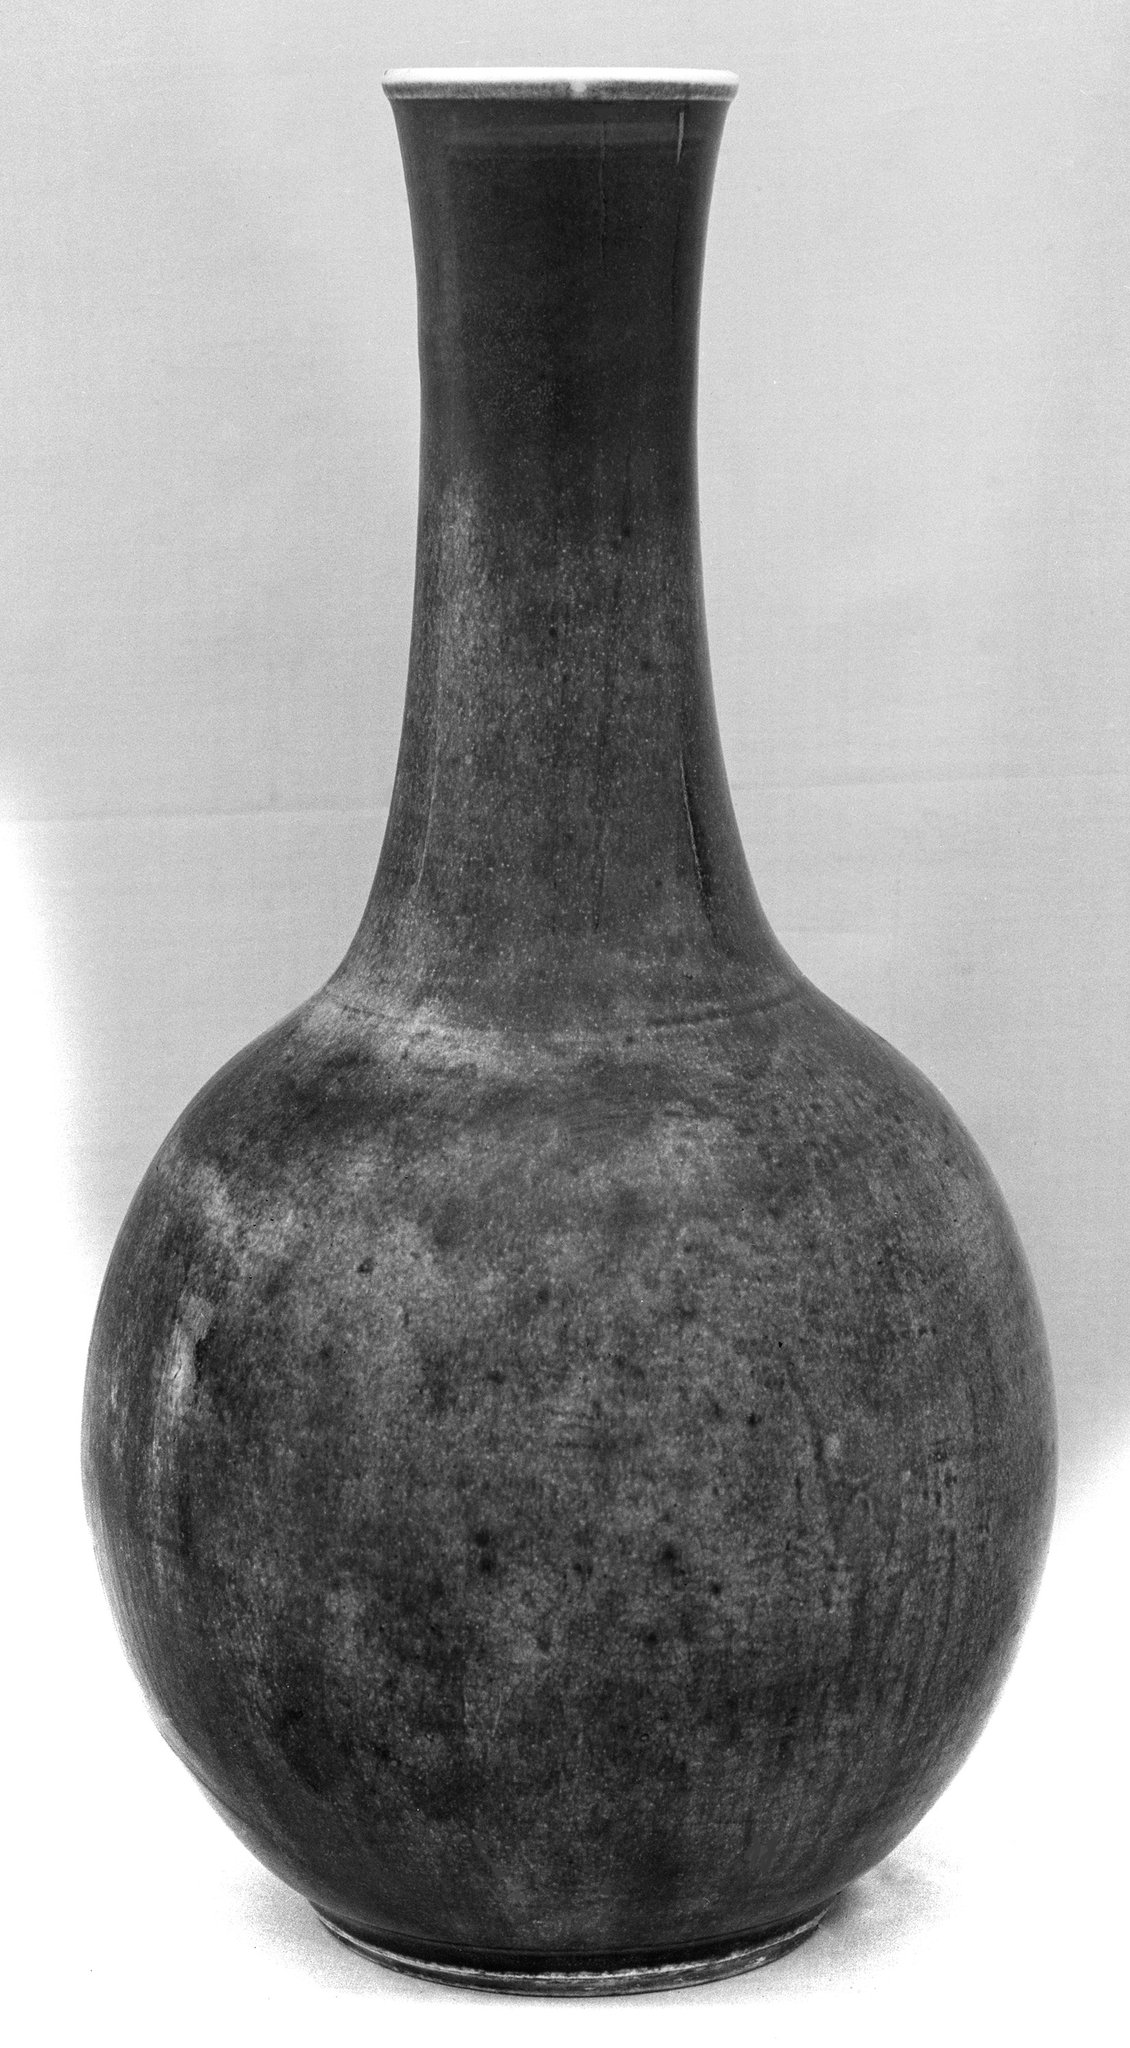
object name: bottle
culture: chinese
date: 1662-1722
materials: porcelain